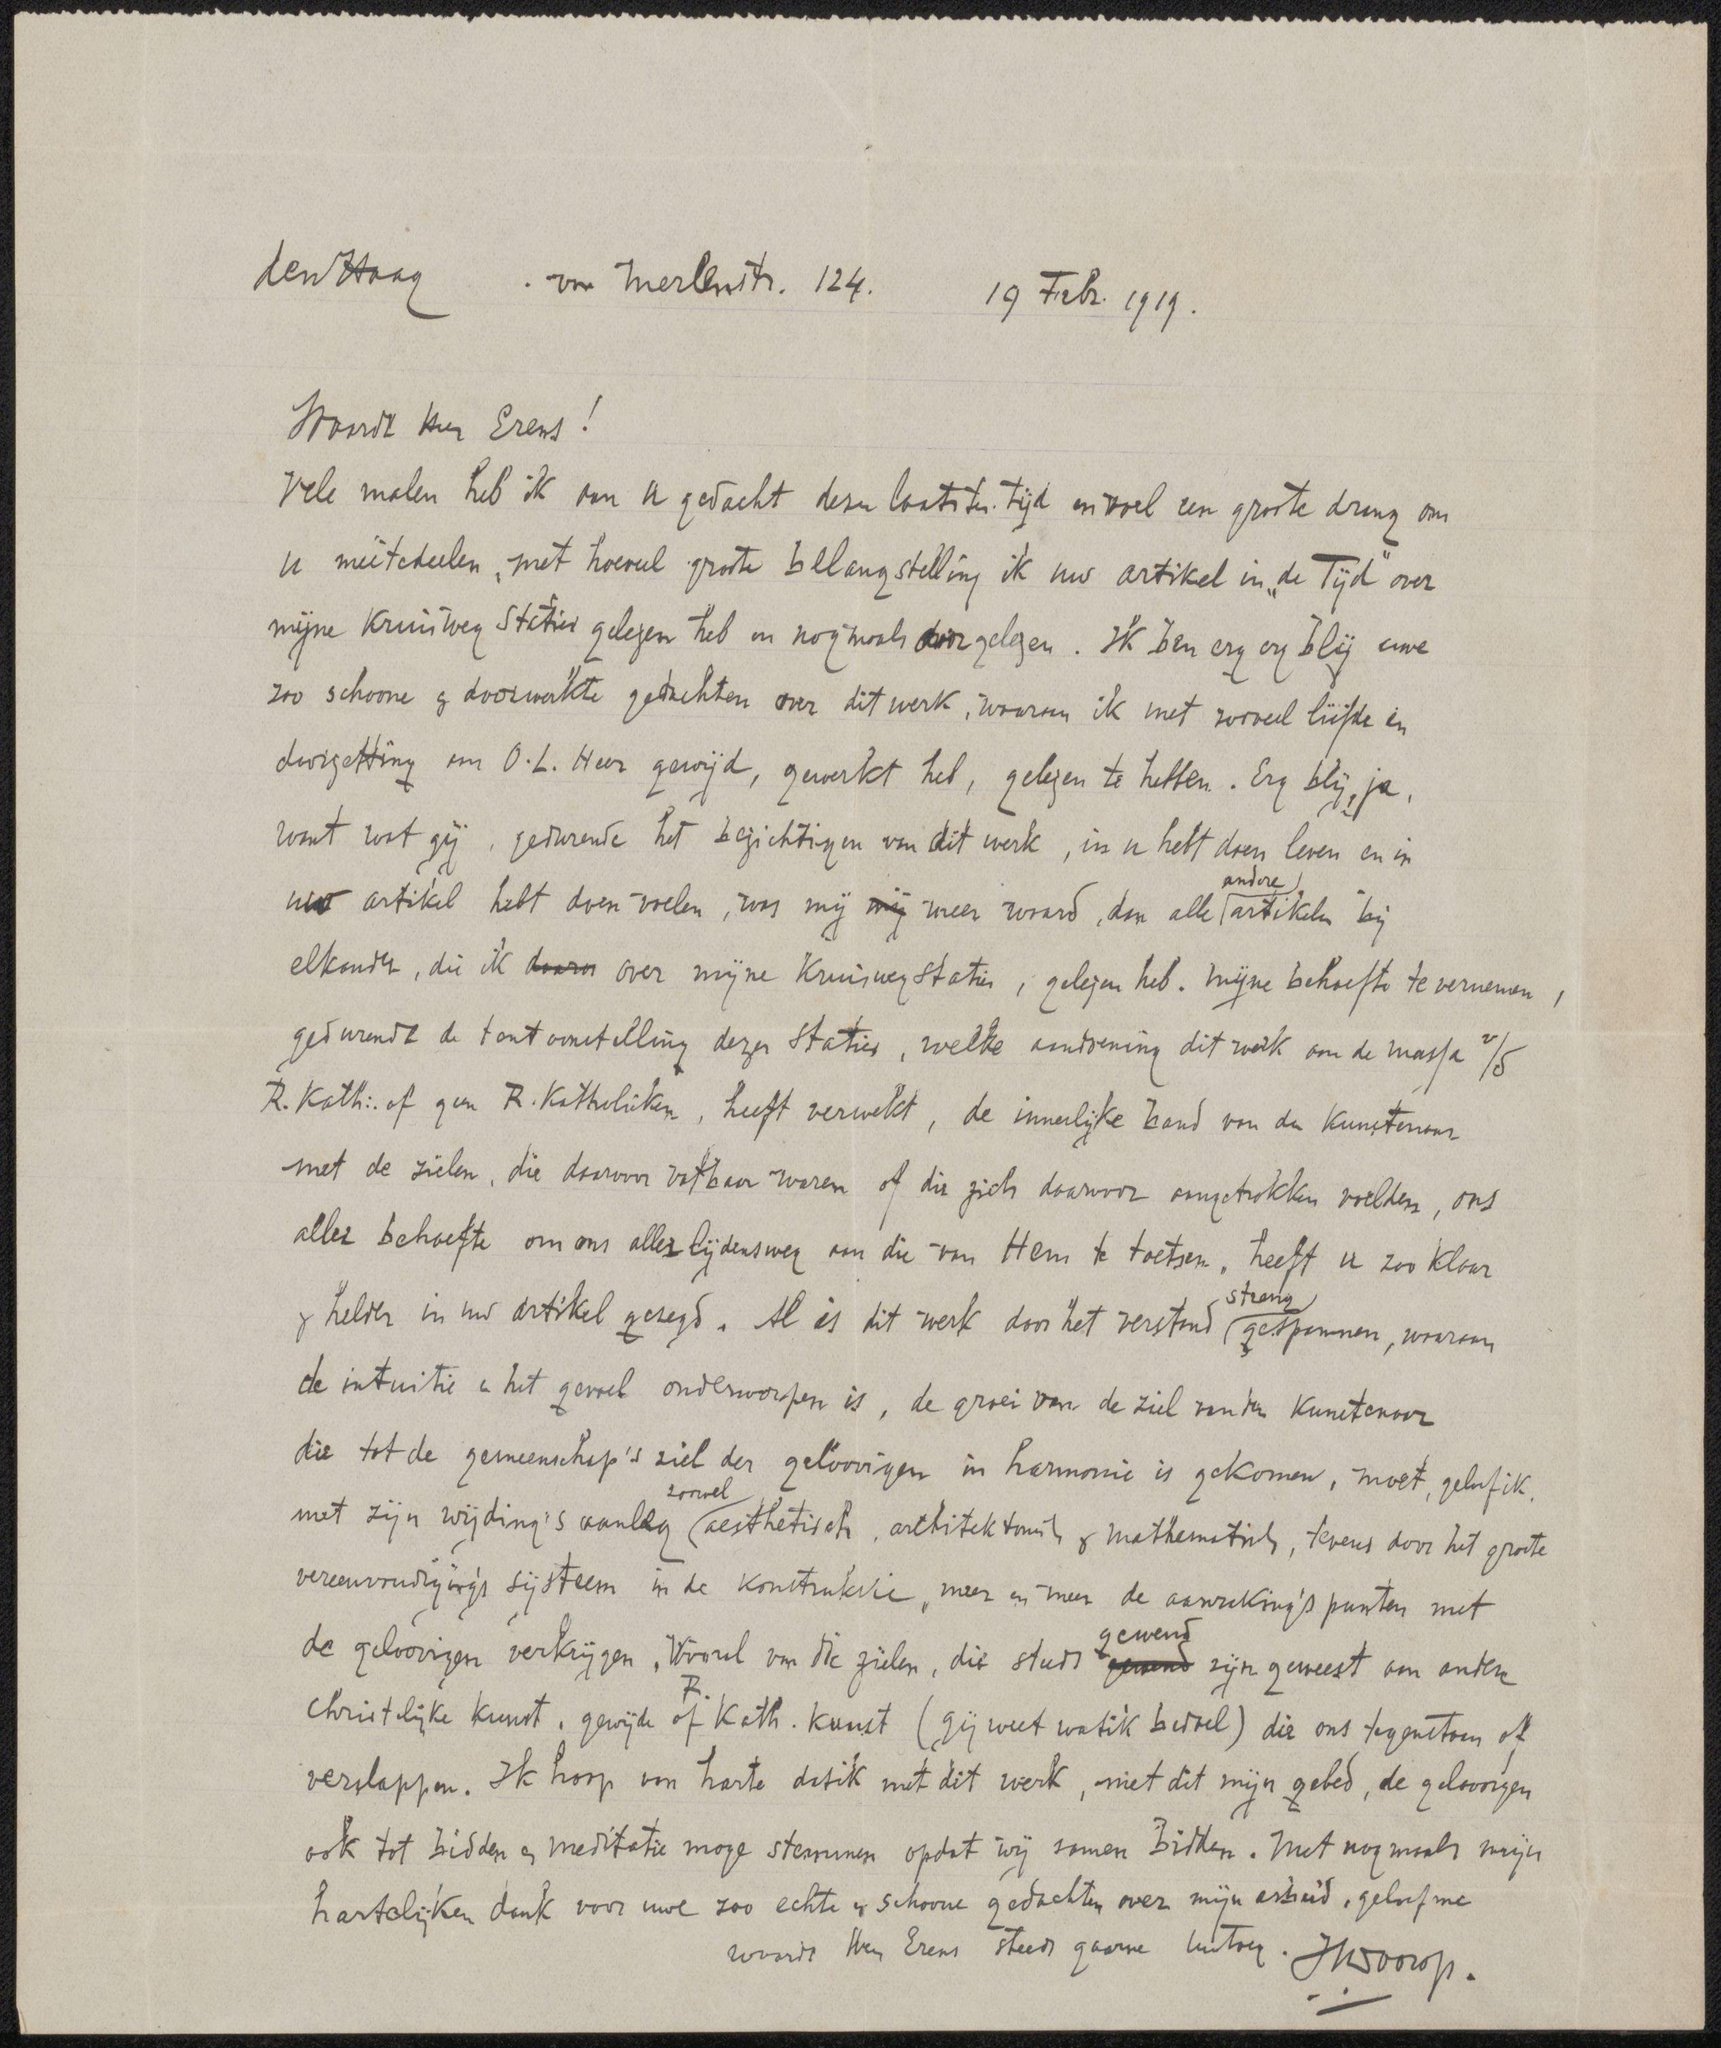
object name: letter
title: Brief aan Frans Erens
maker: jan toorop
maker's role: draughtsman, painter, print maker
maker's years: 1858-1928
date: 1919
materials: ink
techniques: pen, writing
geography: the hague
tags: frans erens, criticizing and discussing art, art criticism, christian religion